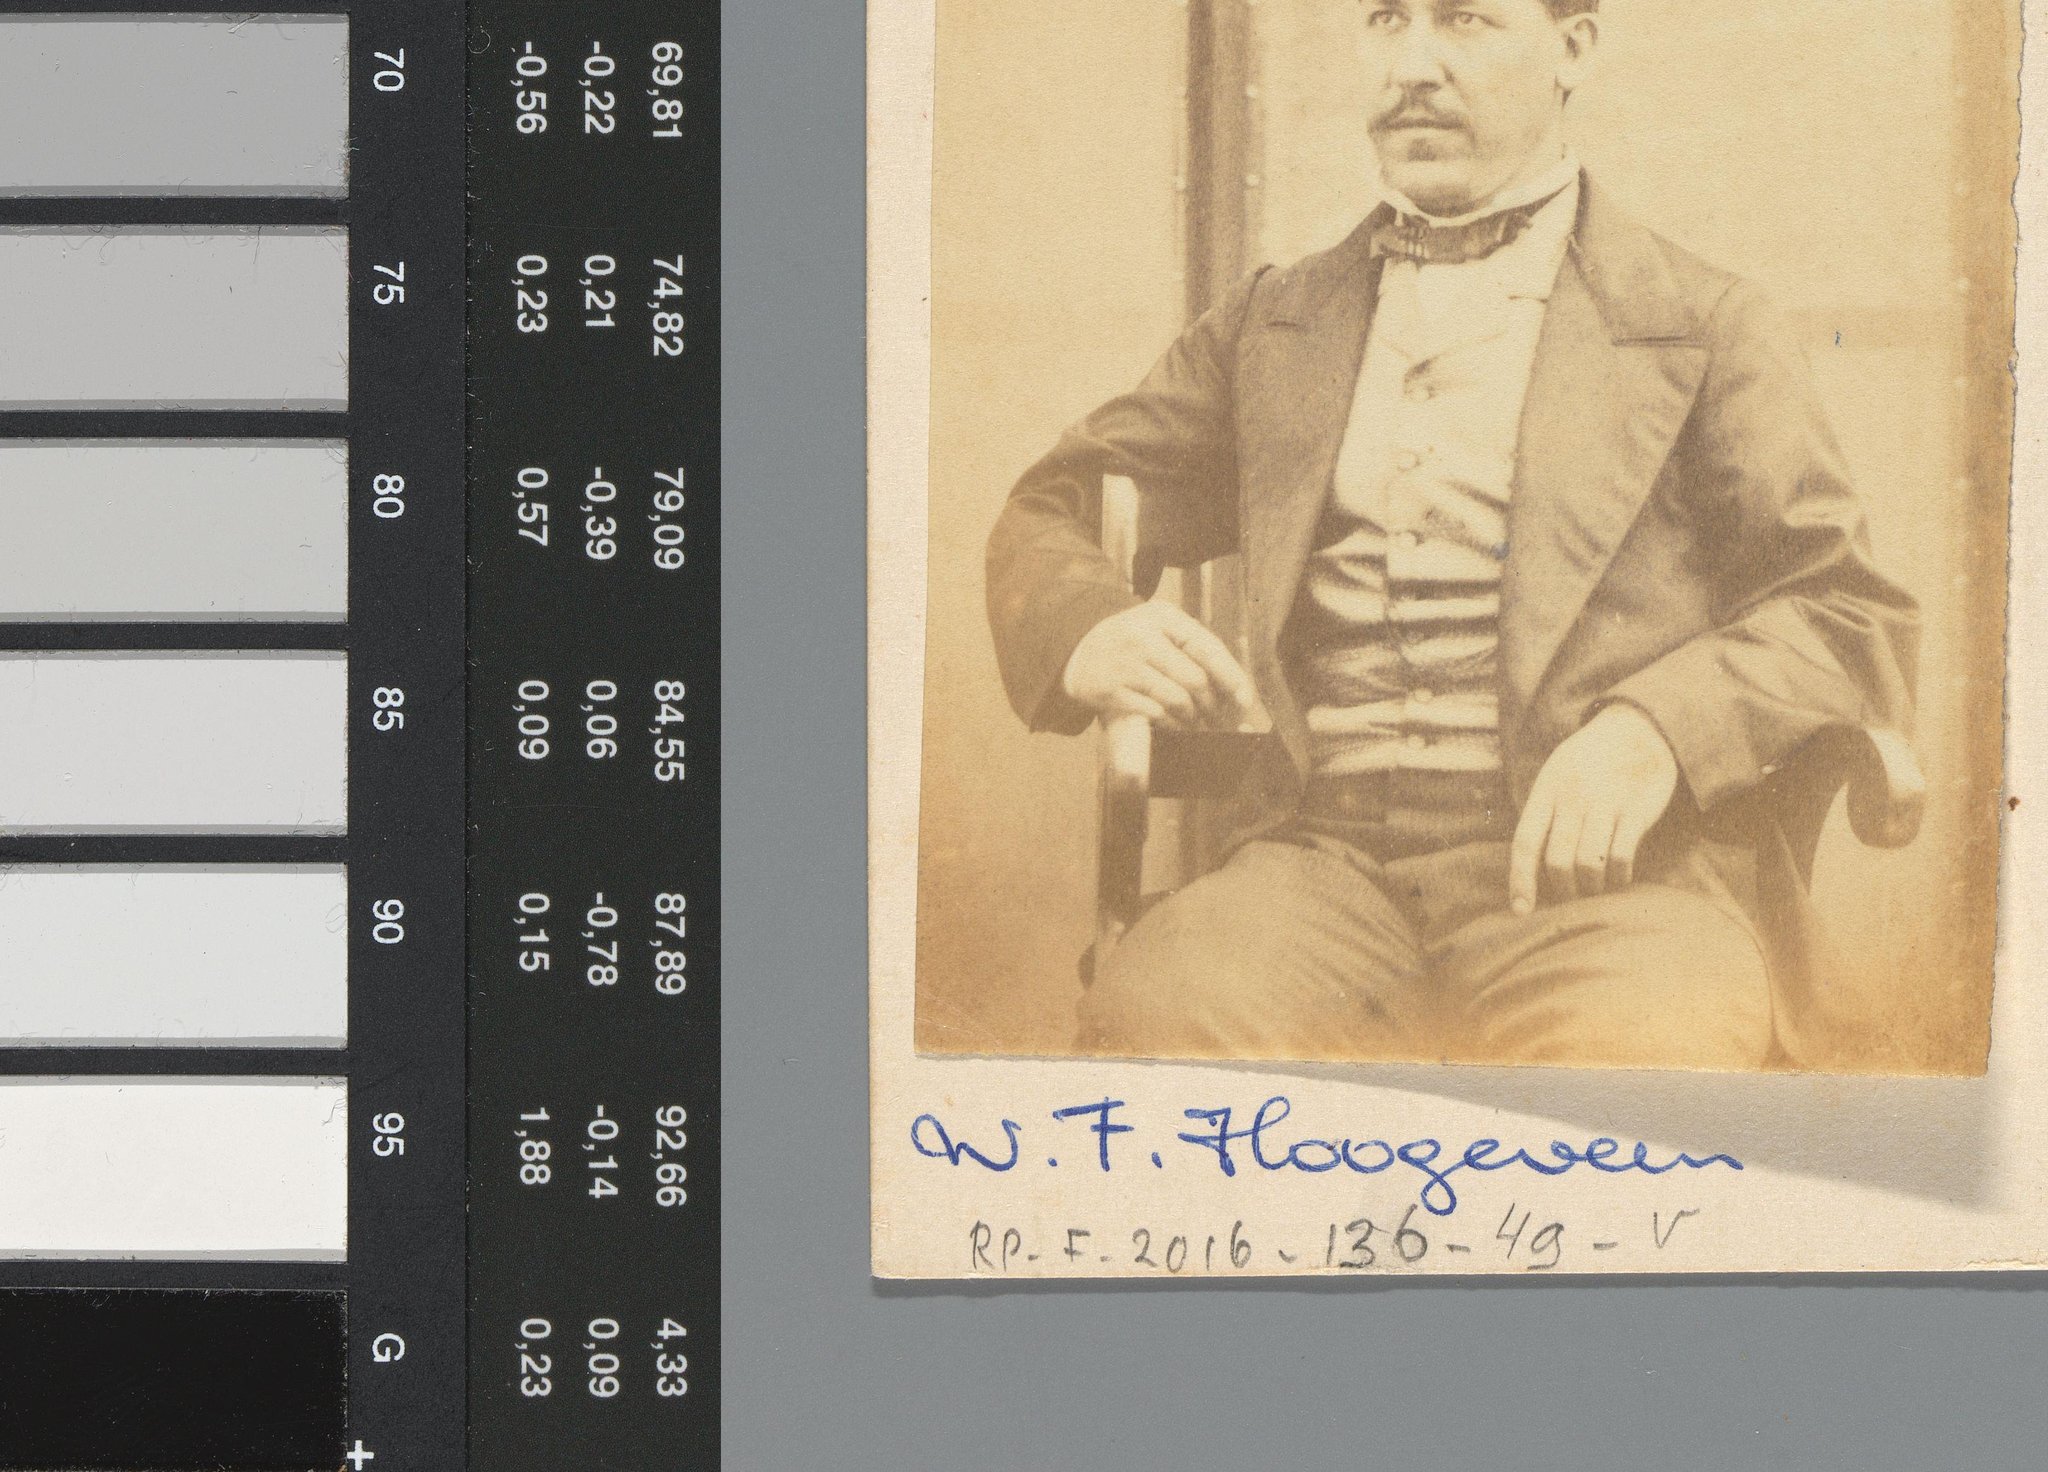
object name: photograph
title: Portret van W.F. Hoogeveen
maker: Anonymous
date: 1855-1910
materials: cardboard, photographic support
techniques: albumen print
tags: w.f. hoogeveen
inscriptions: name: ‘W.F. Hoogeveen’